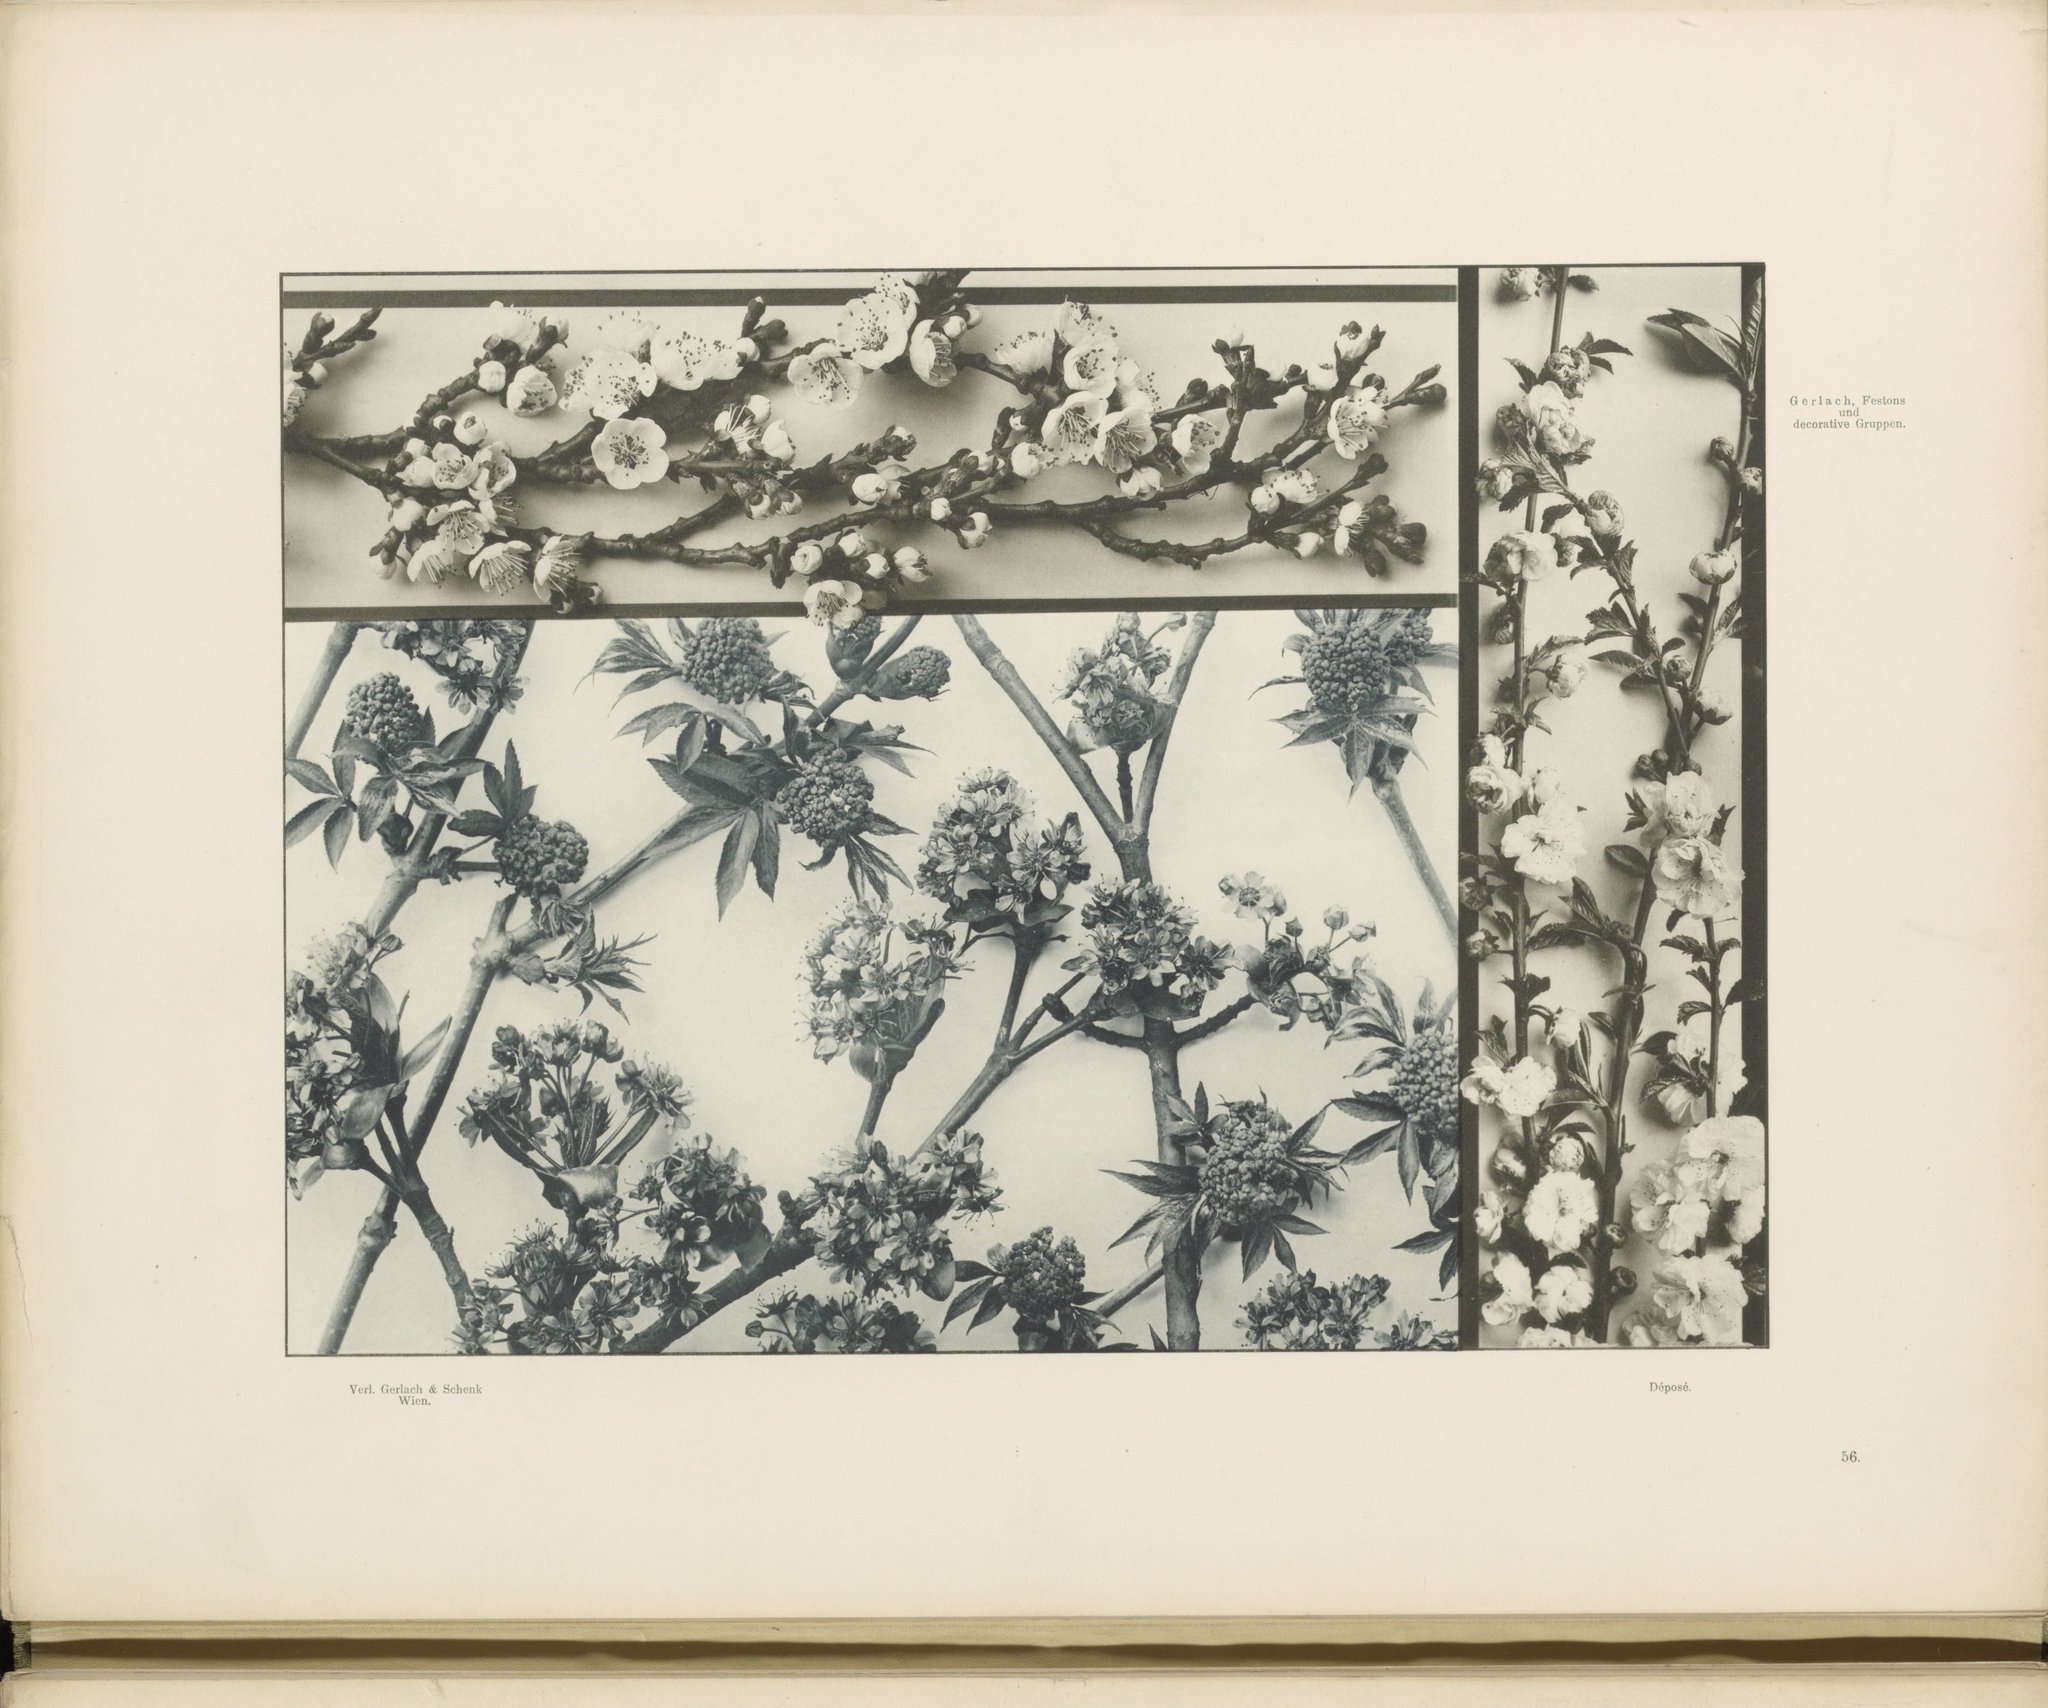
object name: page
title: Vlakken met amandelbloesem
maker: Anonymous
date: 1887-1897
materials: paper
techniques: photograph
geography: austria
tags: (almond-blossom) flowers: almond-blossom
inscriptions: number: ‘56.’